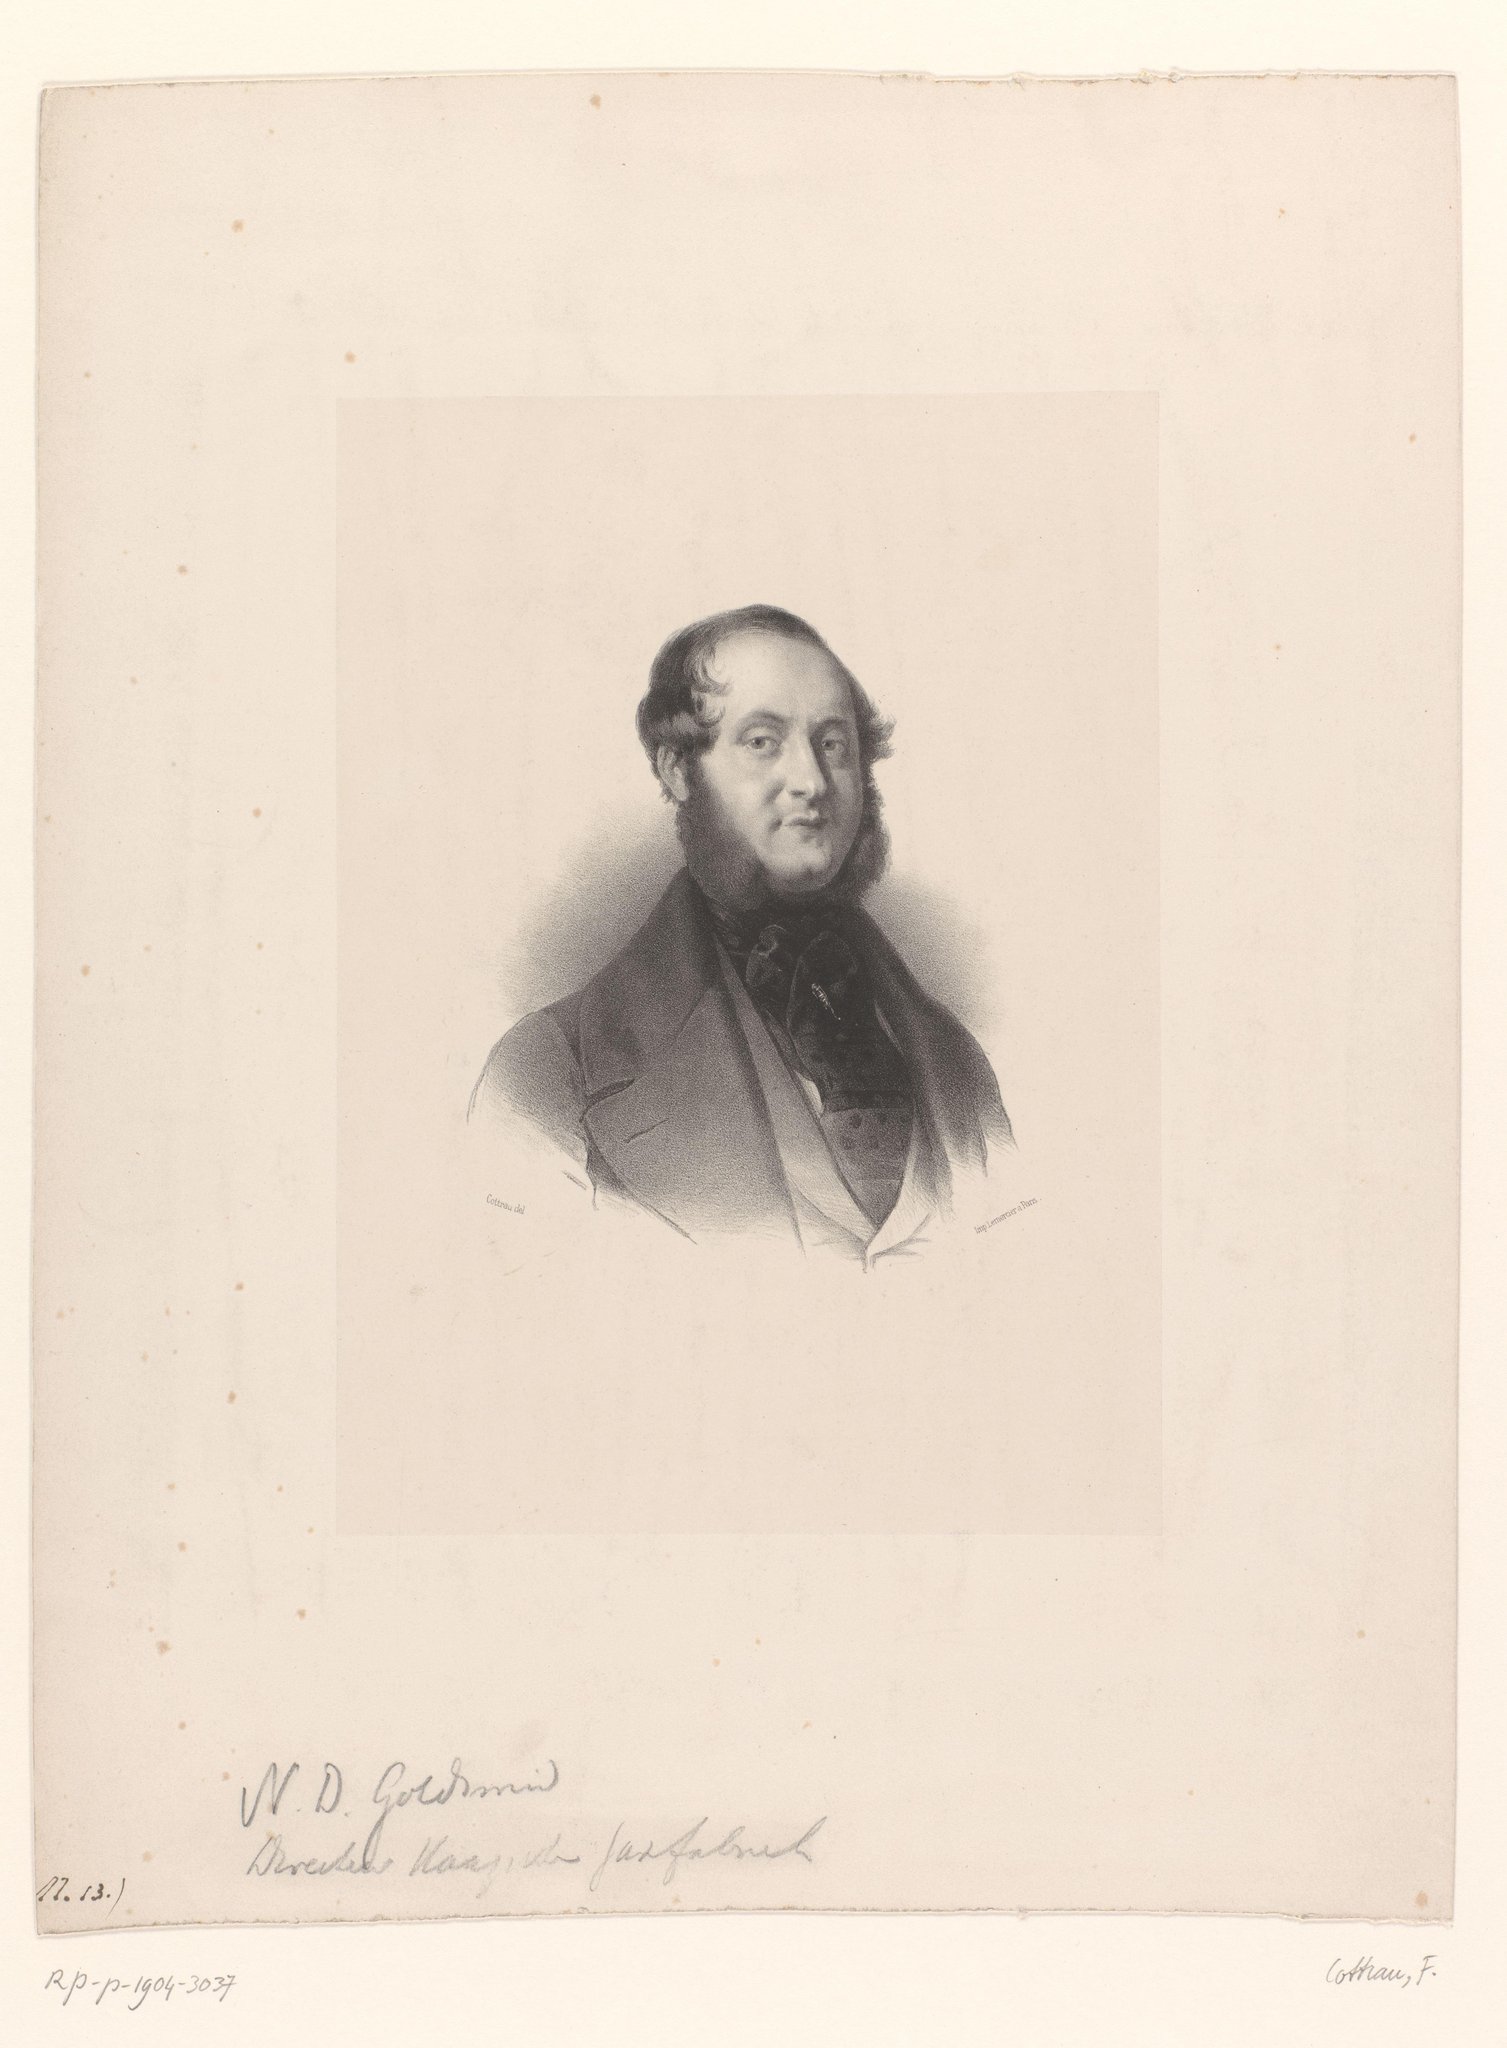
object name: print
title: Portret van de verzamelaar Neville Davison Goldsmid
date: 1828-1852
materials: paper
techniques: lithograph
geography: paris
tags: historical persons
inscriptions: annotation: ‘[...] Haagsch [...]’, number: ‘17’, collector's mark: Lugt 2228a, number: ‘13’